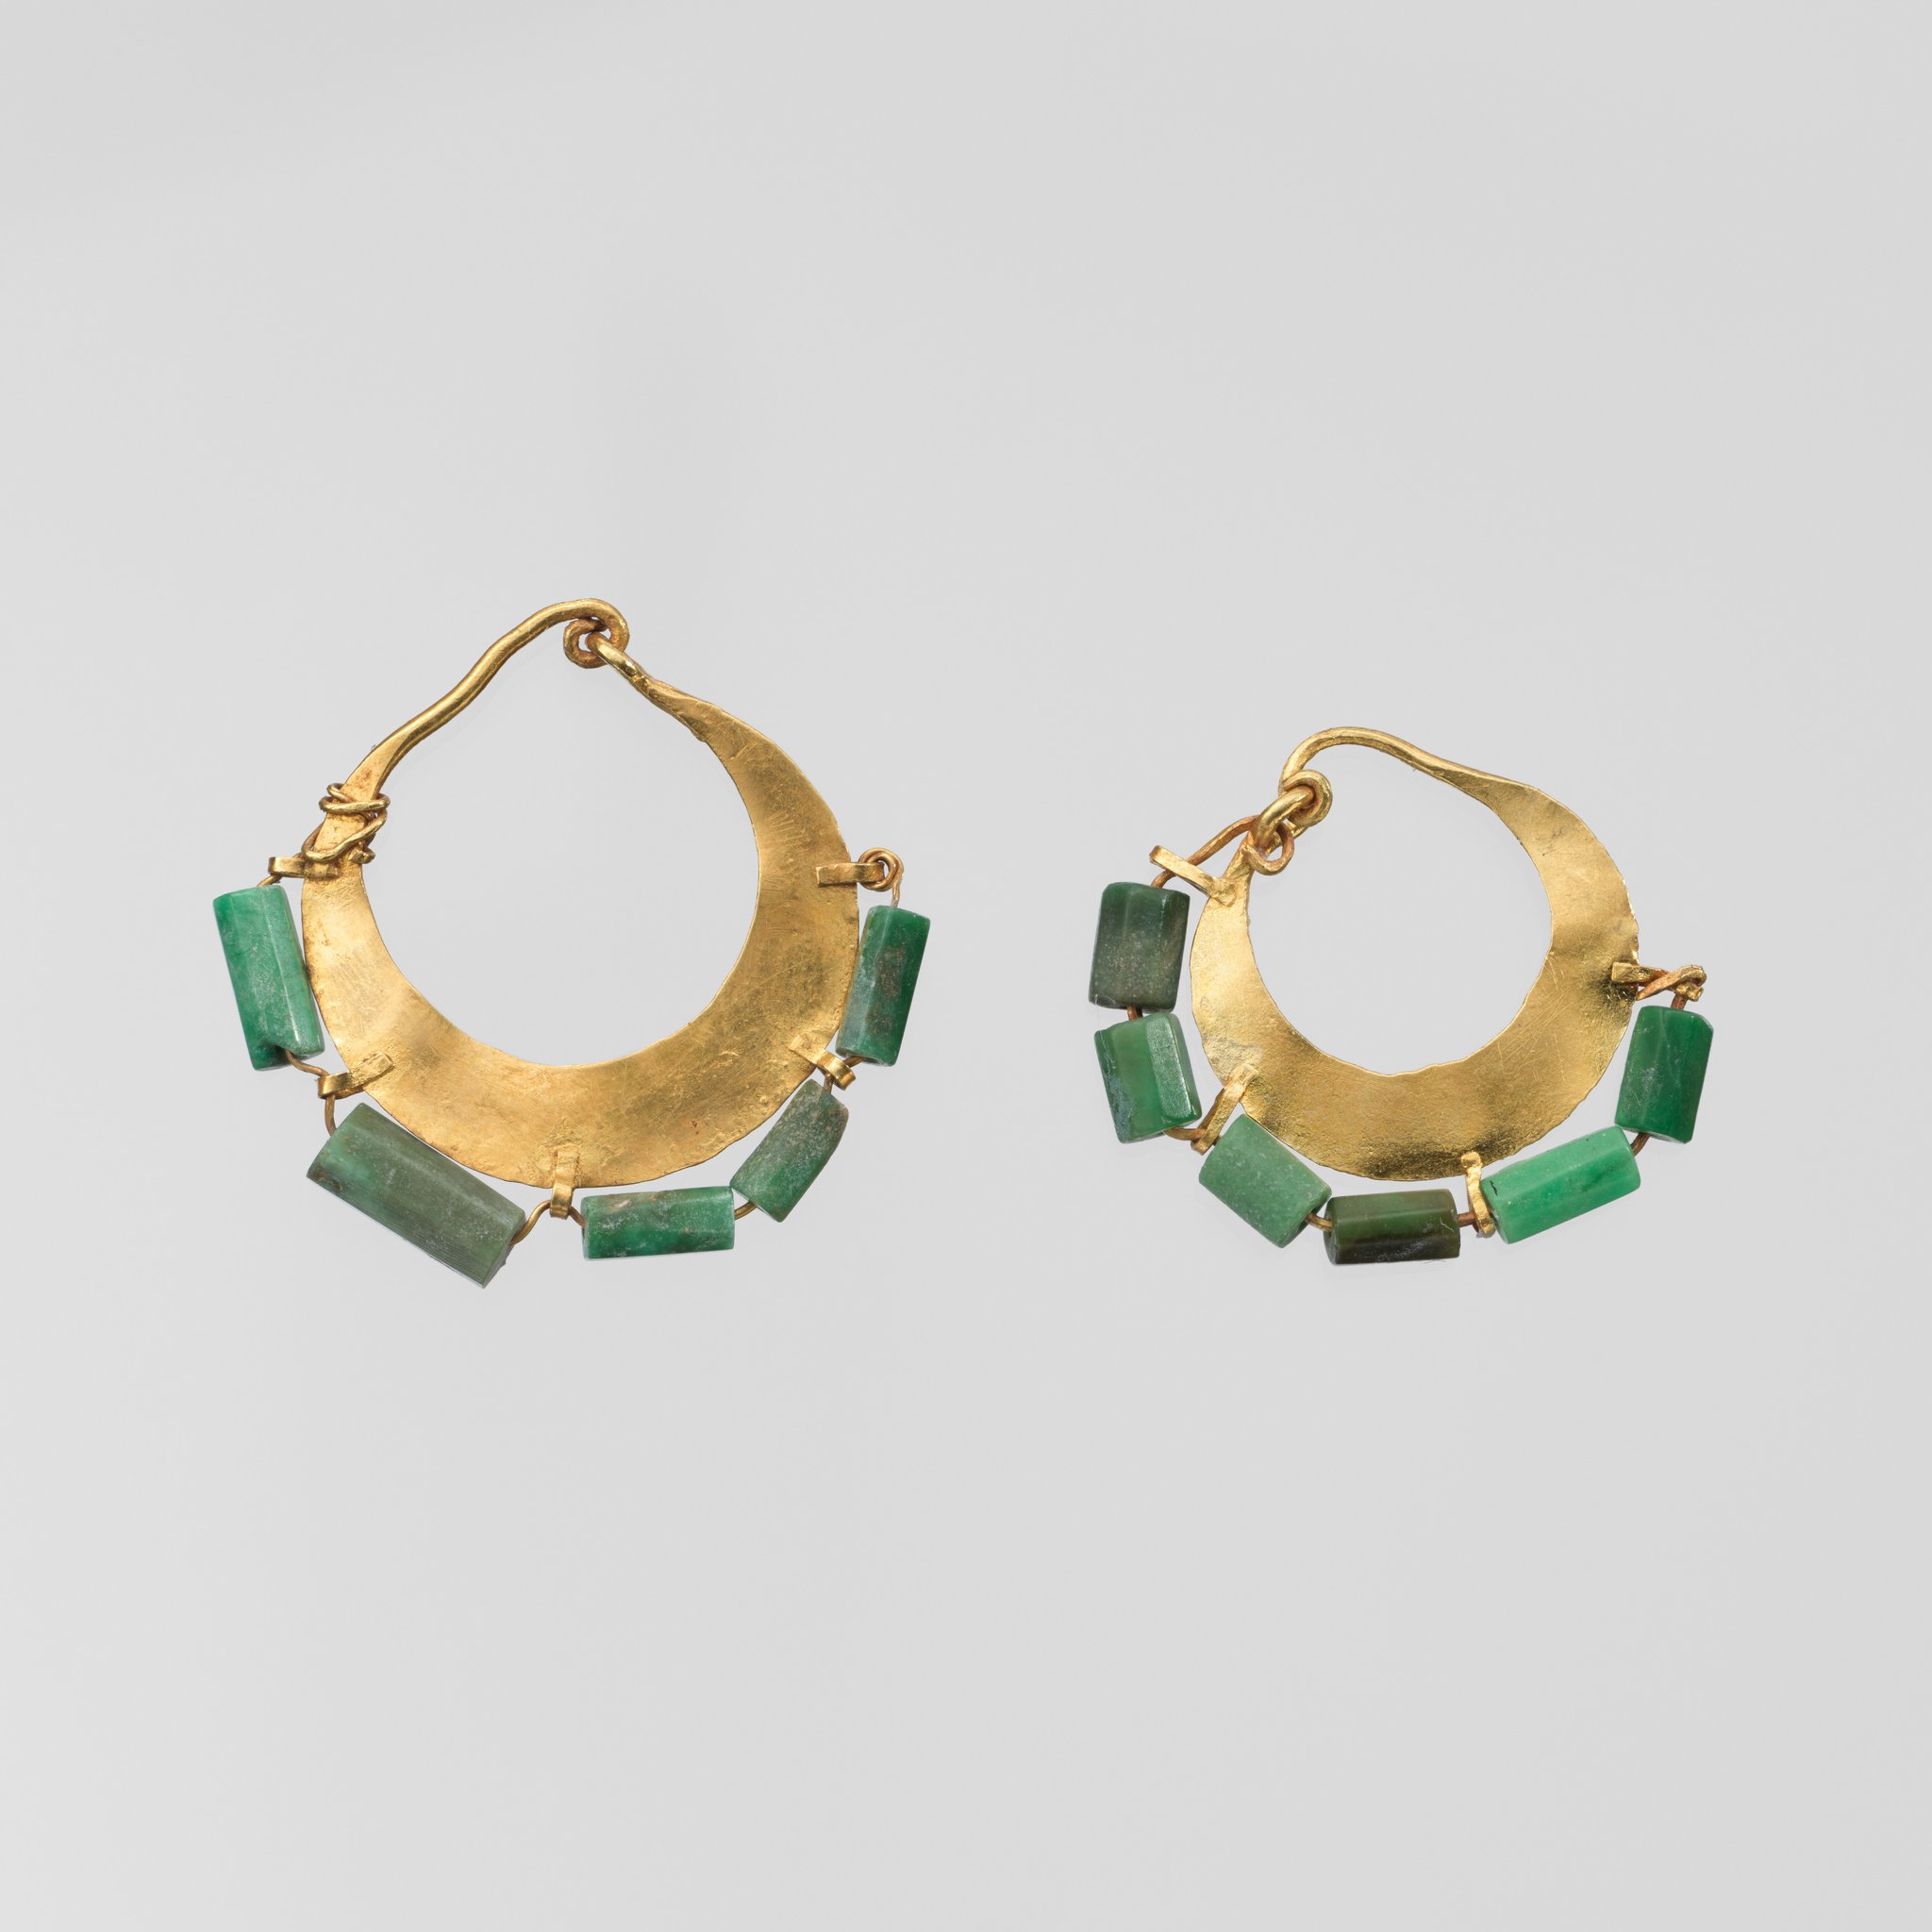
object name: earring, crescent shaped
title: Gold and variscite earring (one of a pair)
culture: roman, cypriot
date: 101-200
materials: stone, gold